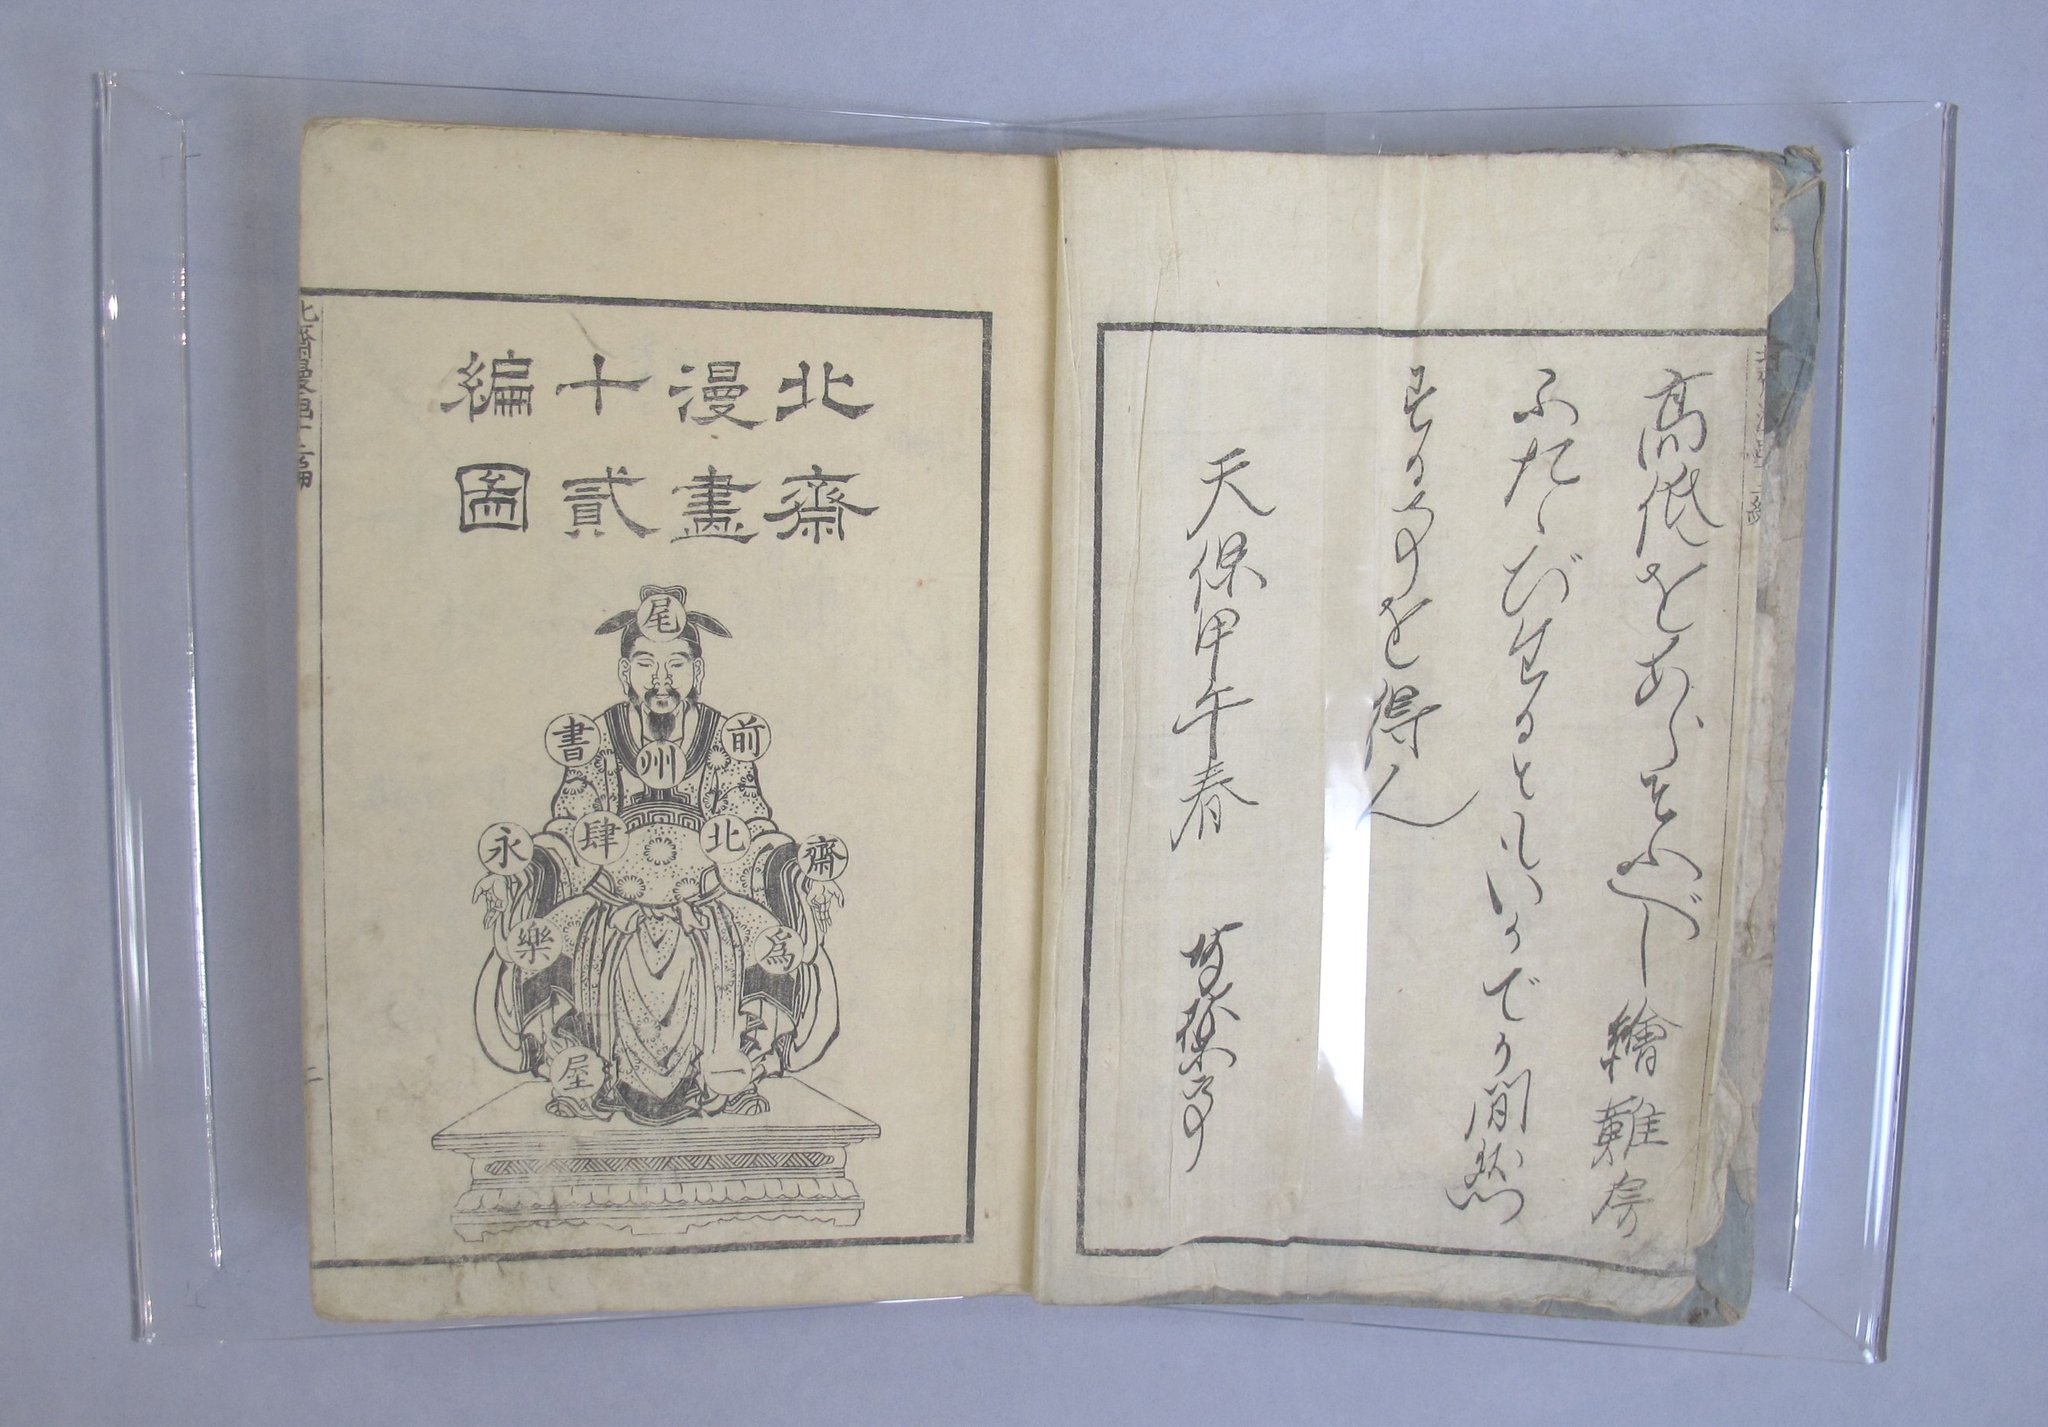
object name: illustrated book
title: Transmitting the Spirit, Revealing the Form of Things: Hokusai Sketchbooks, volume 12 (Denshin kaishu: Hokusai manga, jūnihen)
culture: japanese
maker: katsushika hokusai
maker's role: artist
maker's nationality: japanese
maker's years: 1760-1849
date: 1834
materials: ink, paper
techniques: woodblock print